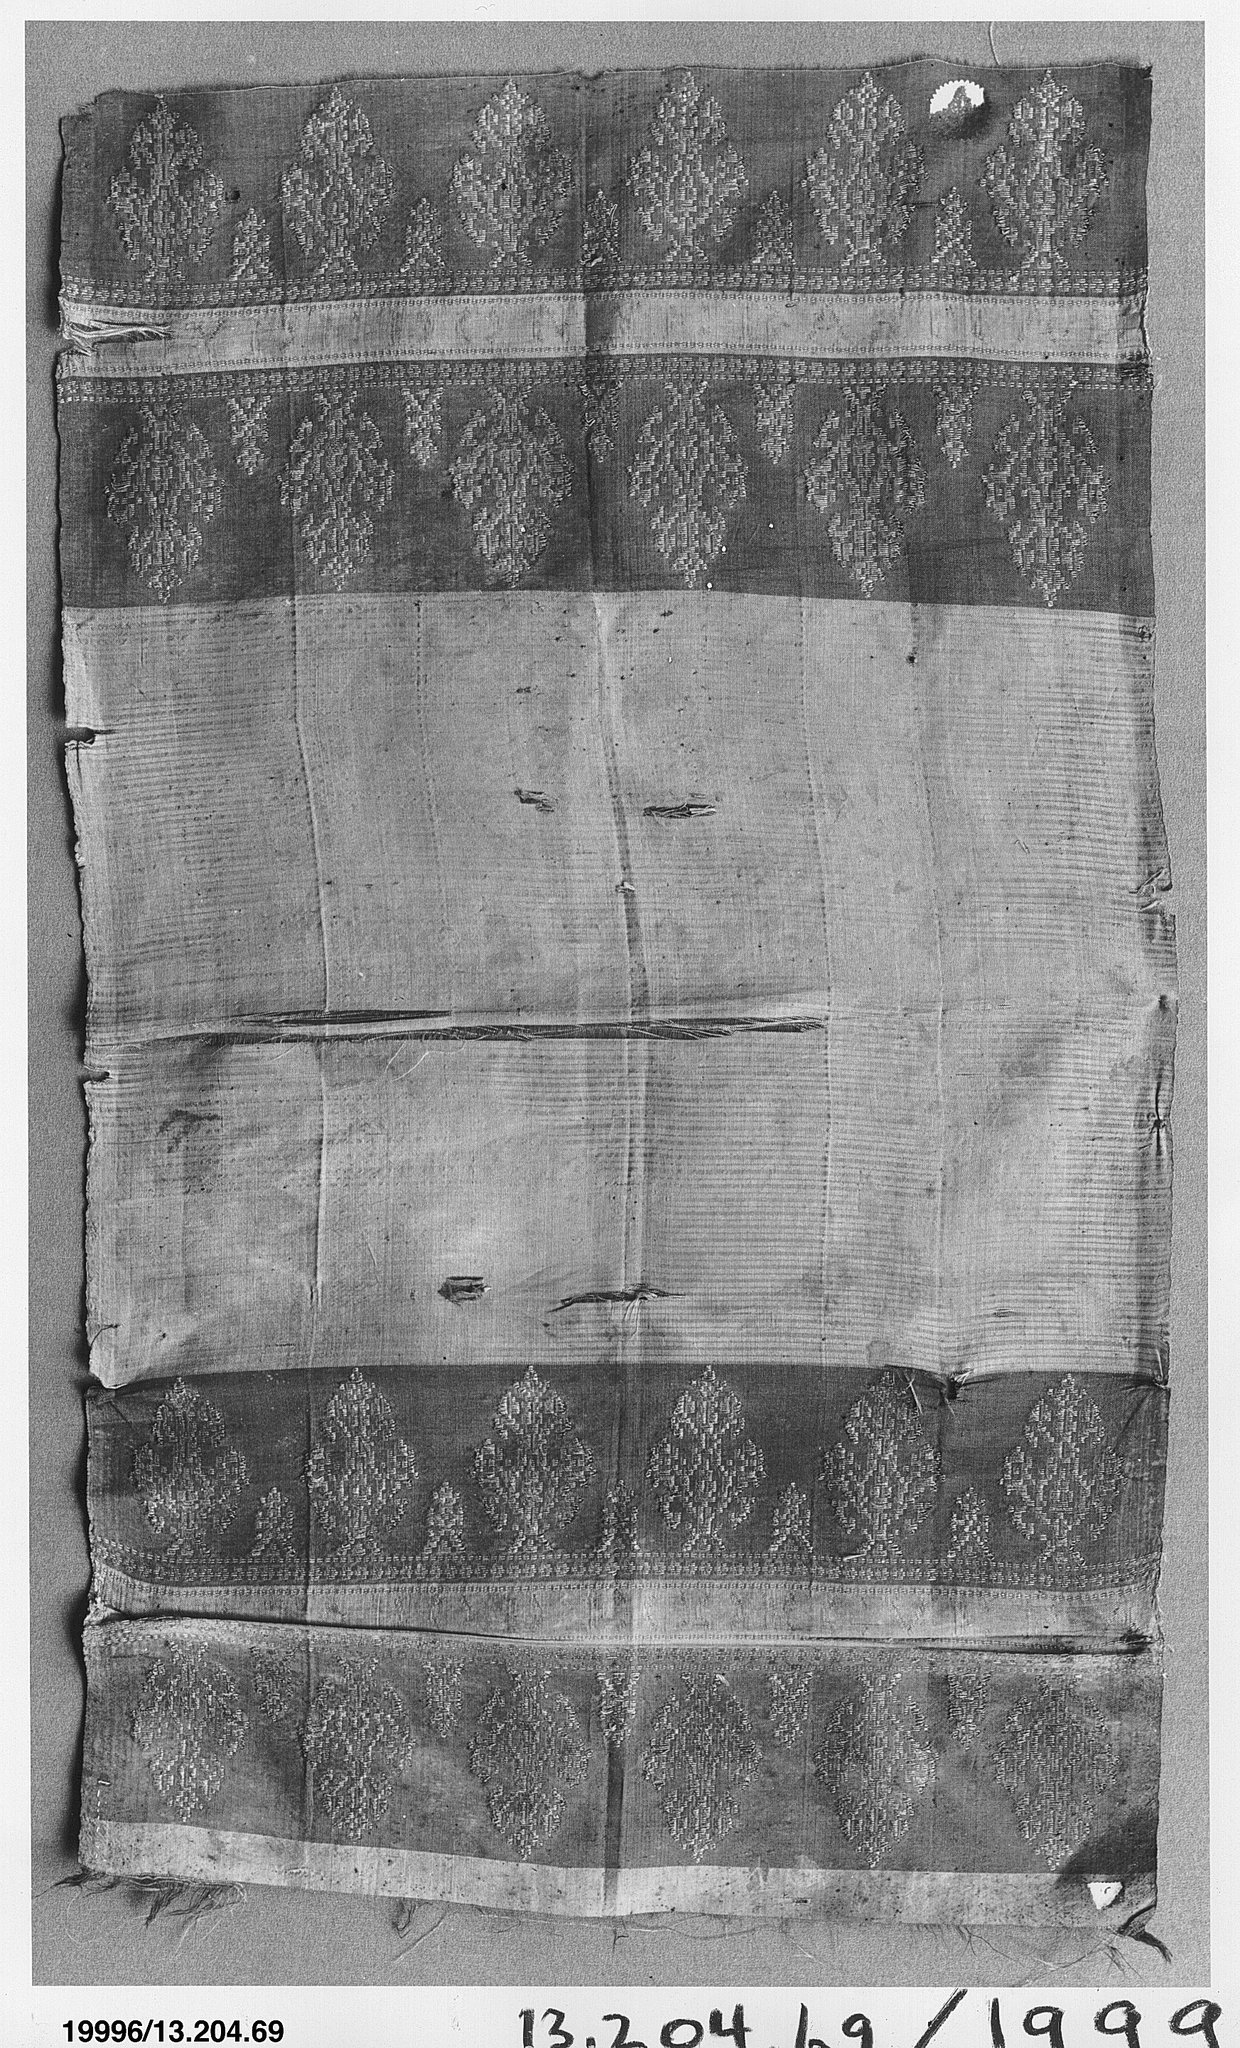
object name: cover fragment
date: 1501-1600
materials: gold thread, silk